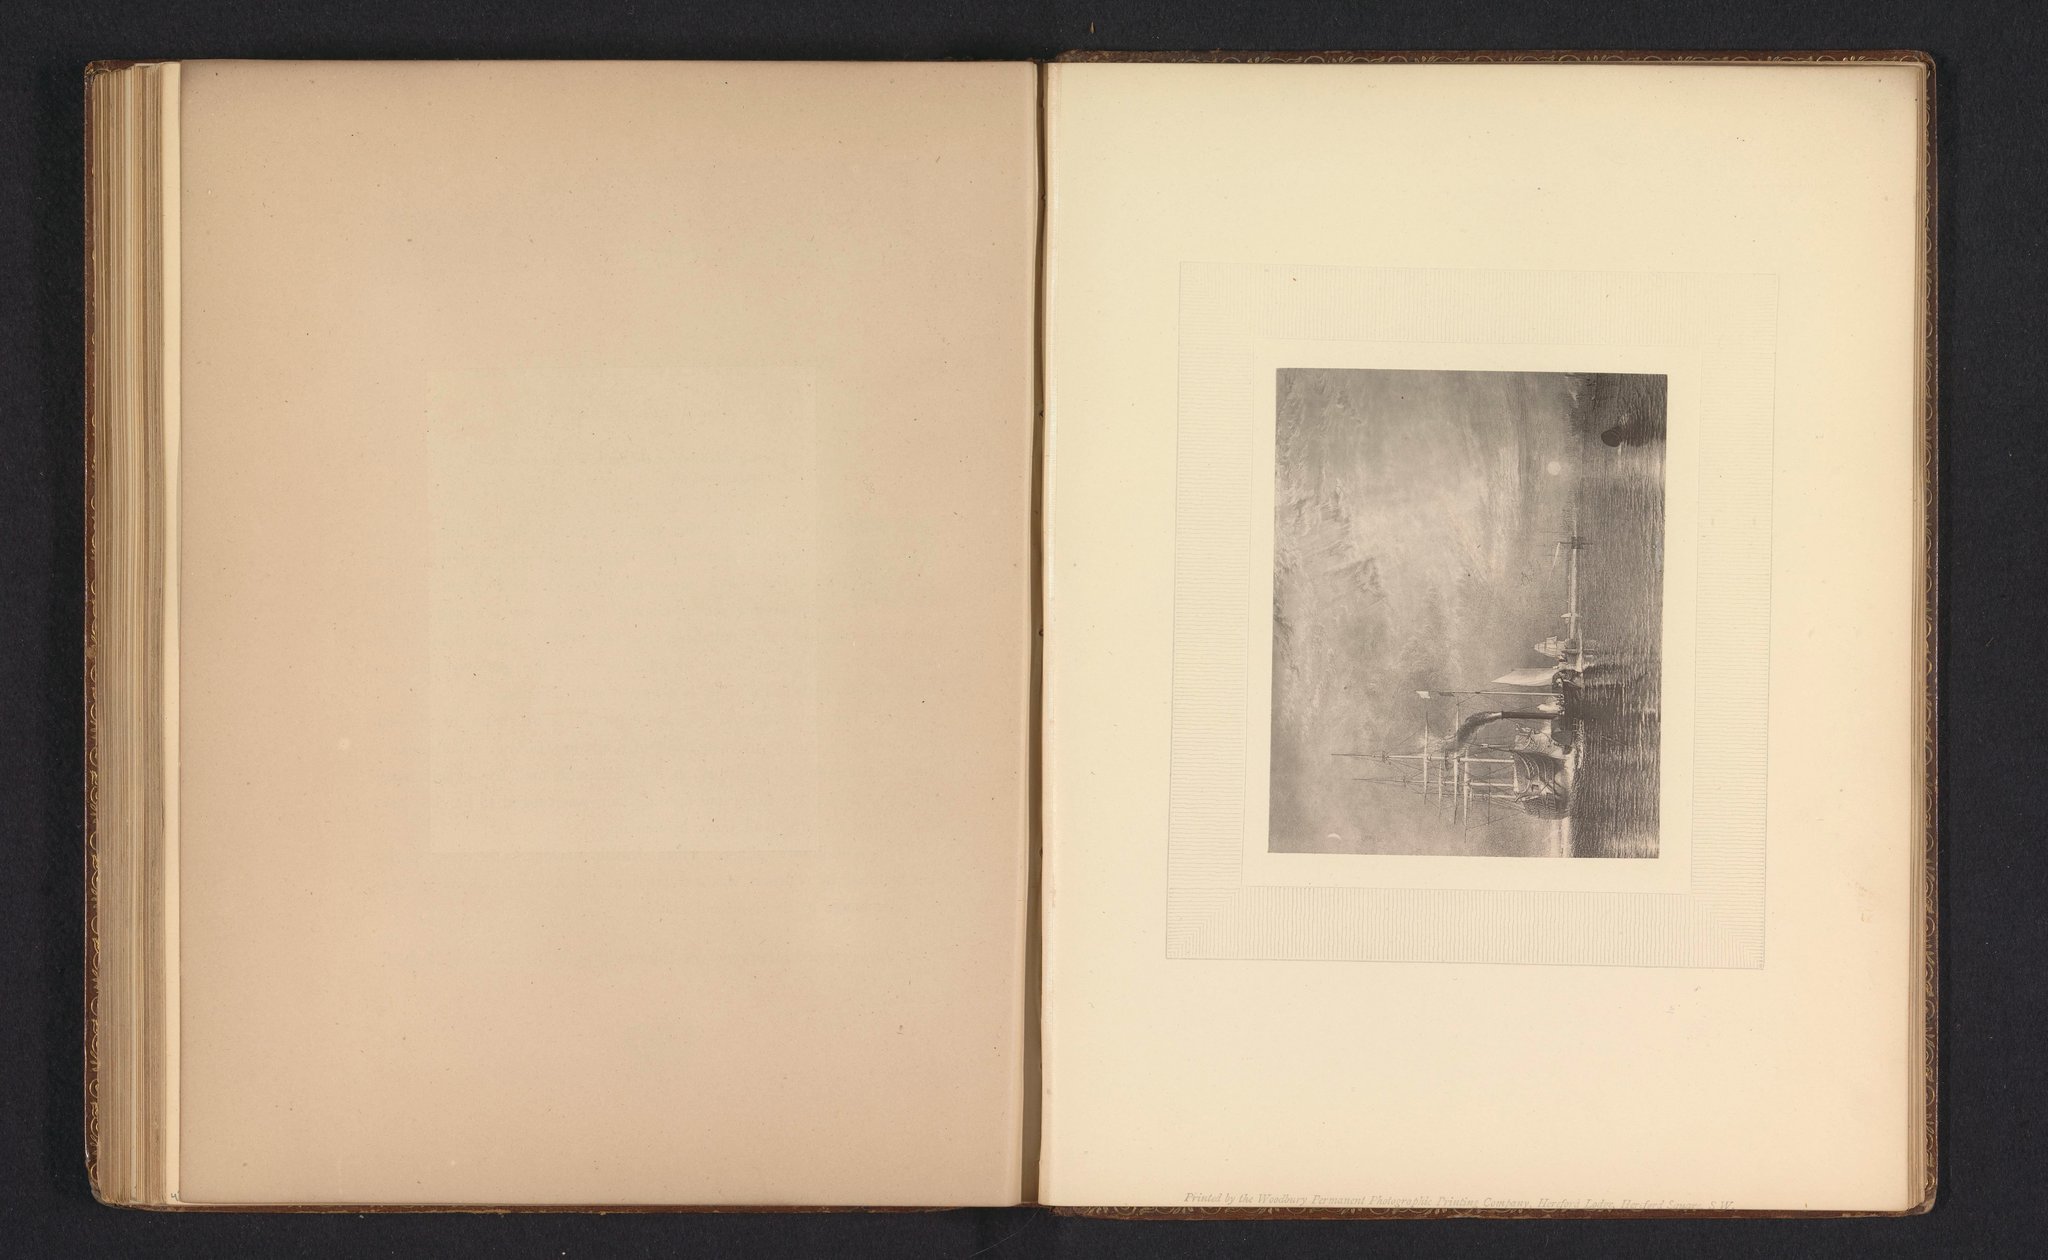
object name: page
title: Fotoreproductie van een prent naar het schilderij The fighting Temeraire door Joseph Mallord William Turner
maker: Anonymous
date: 1864-1874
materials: paper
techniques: woodburytype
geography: london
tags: ships (in general), picture, painting